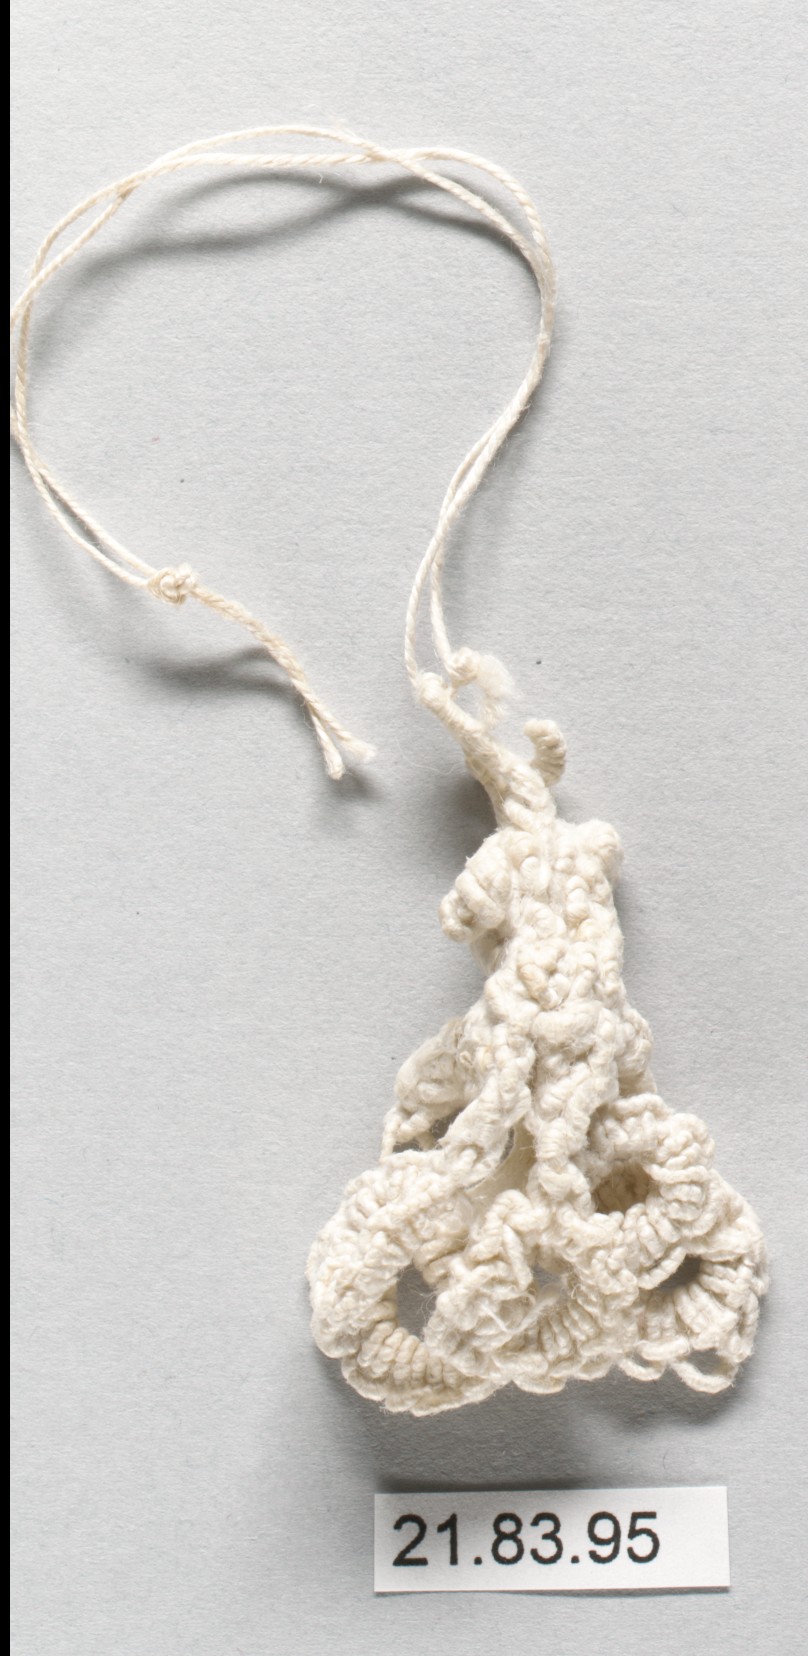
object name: tassel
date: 1601-1700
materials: linen